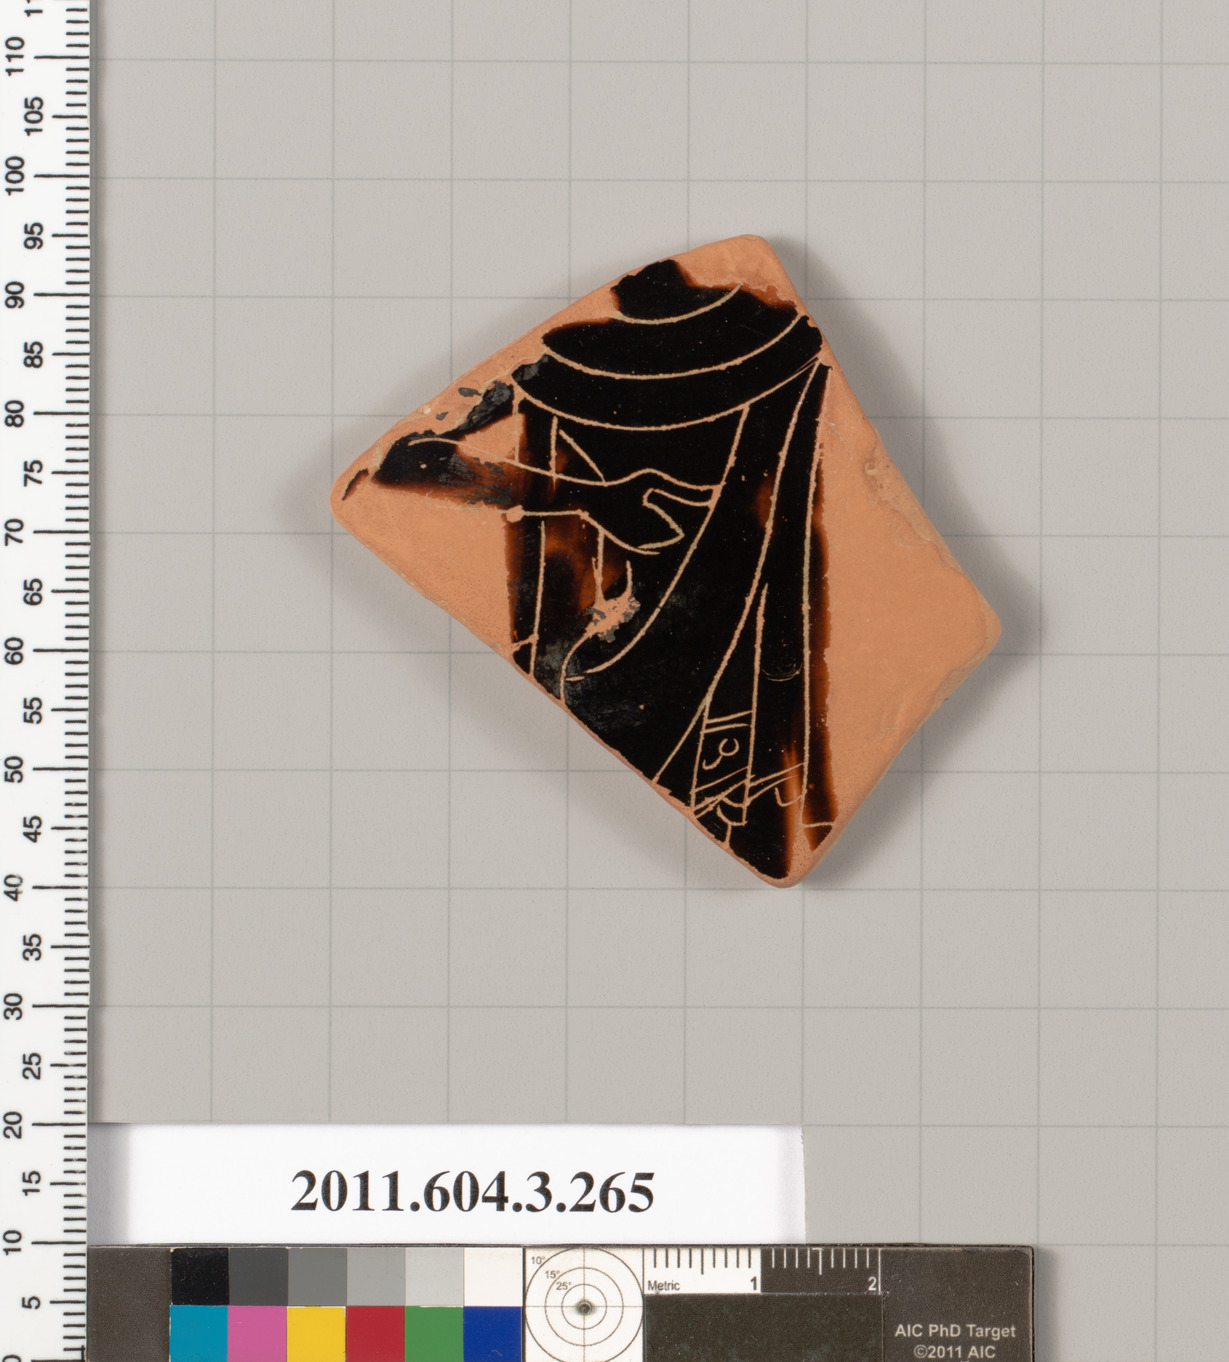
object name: neck amphora fragment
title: Terracotta fragment of a neck-amphora (jar)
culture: greek, attic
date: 500-476 BCE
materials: terracotta